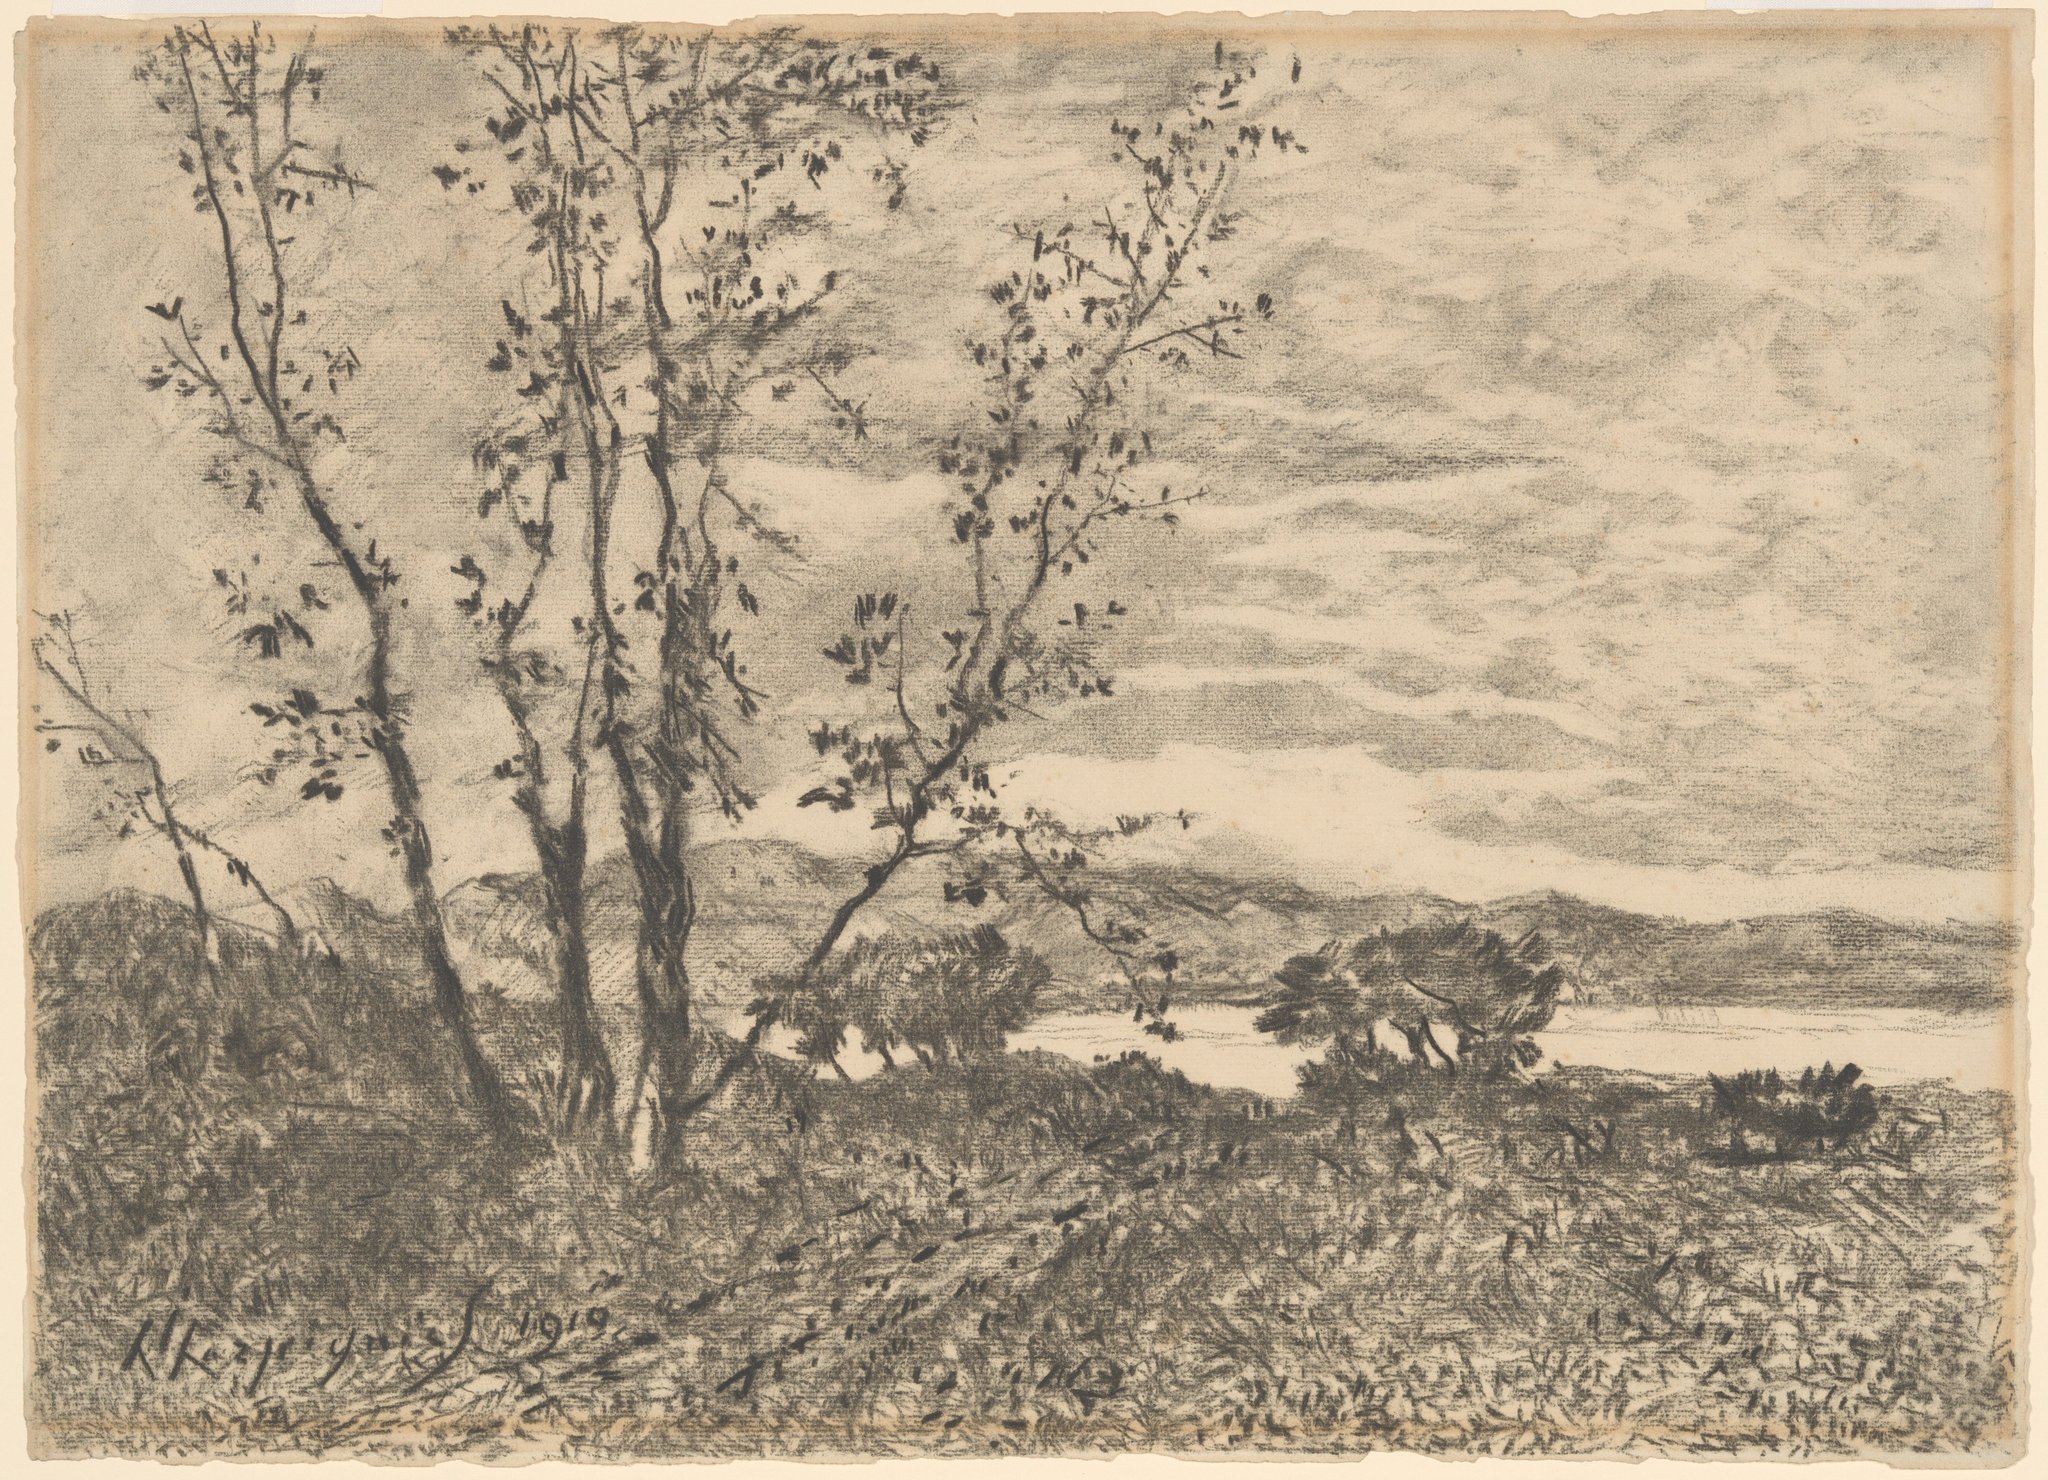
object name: drawing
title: Le Cap Martin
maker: henri-joseph harpignies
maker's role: artist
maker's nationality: french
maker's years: 1819-1916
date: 1910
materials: charcoal, paper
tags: landscapes